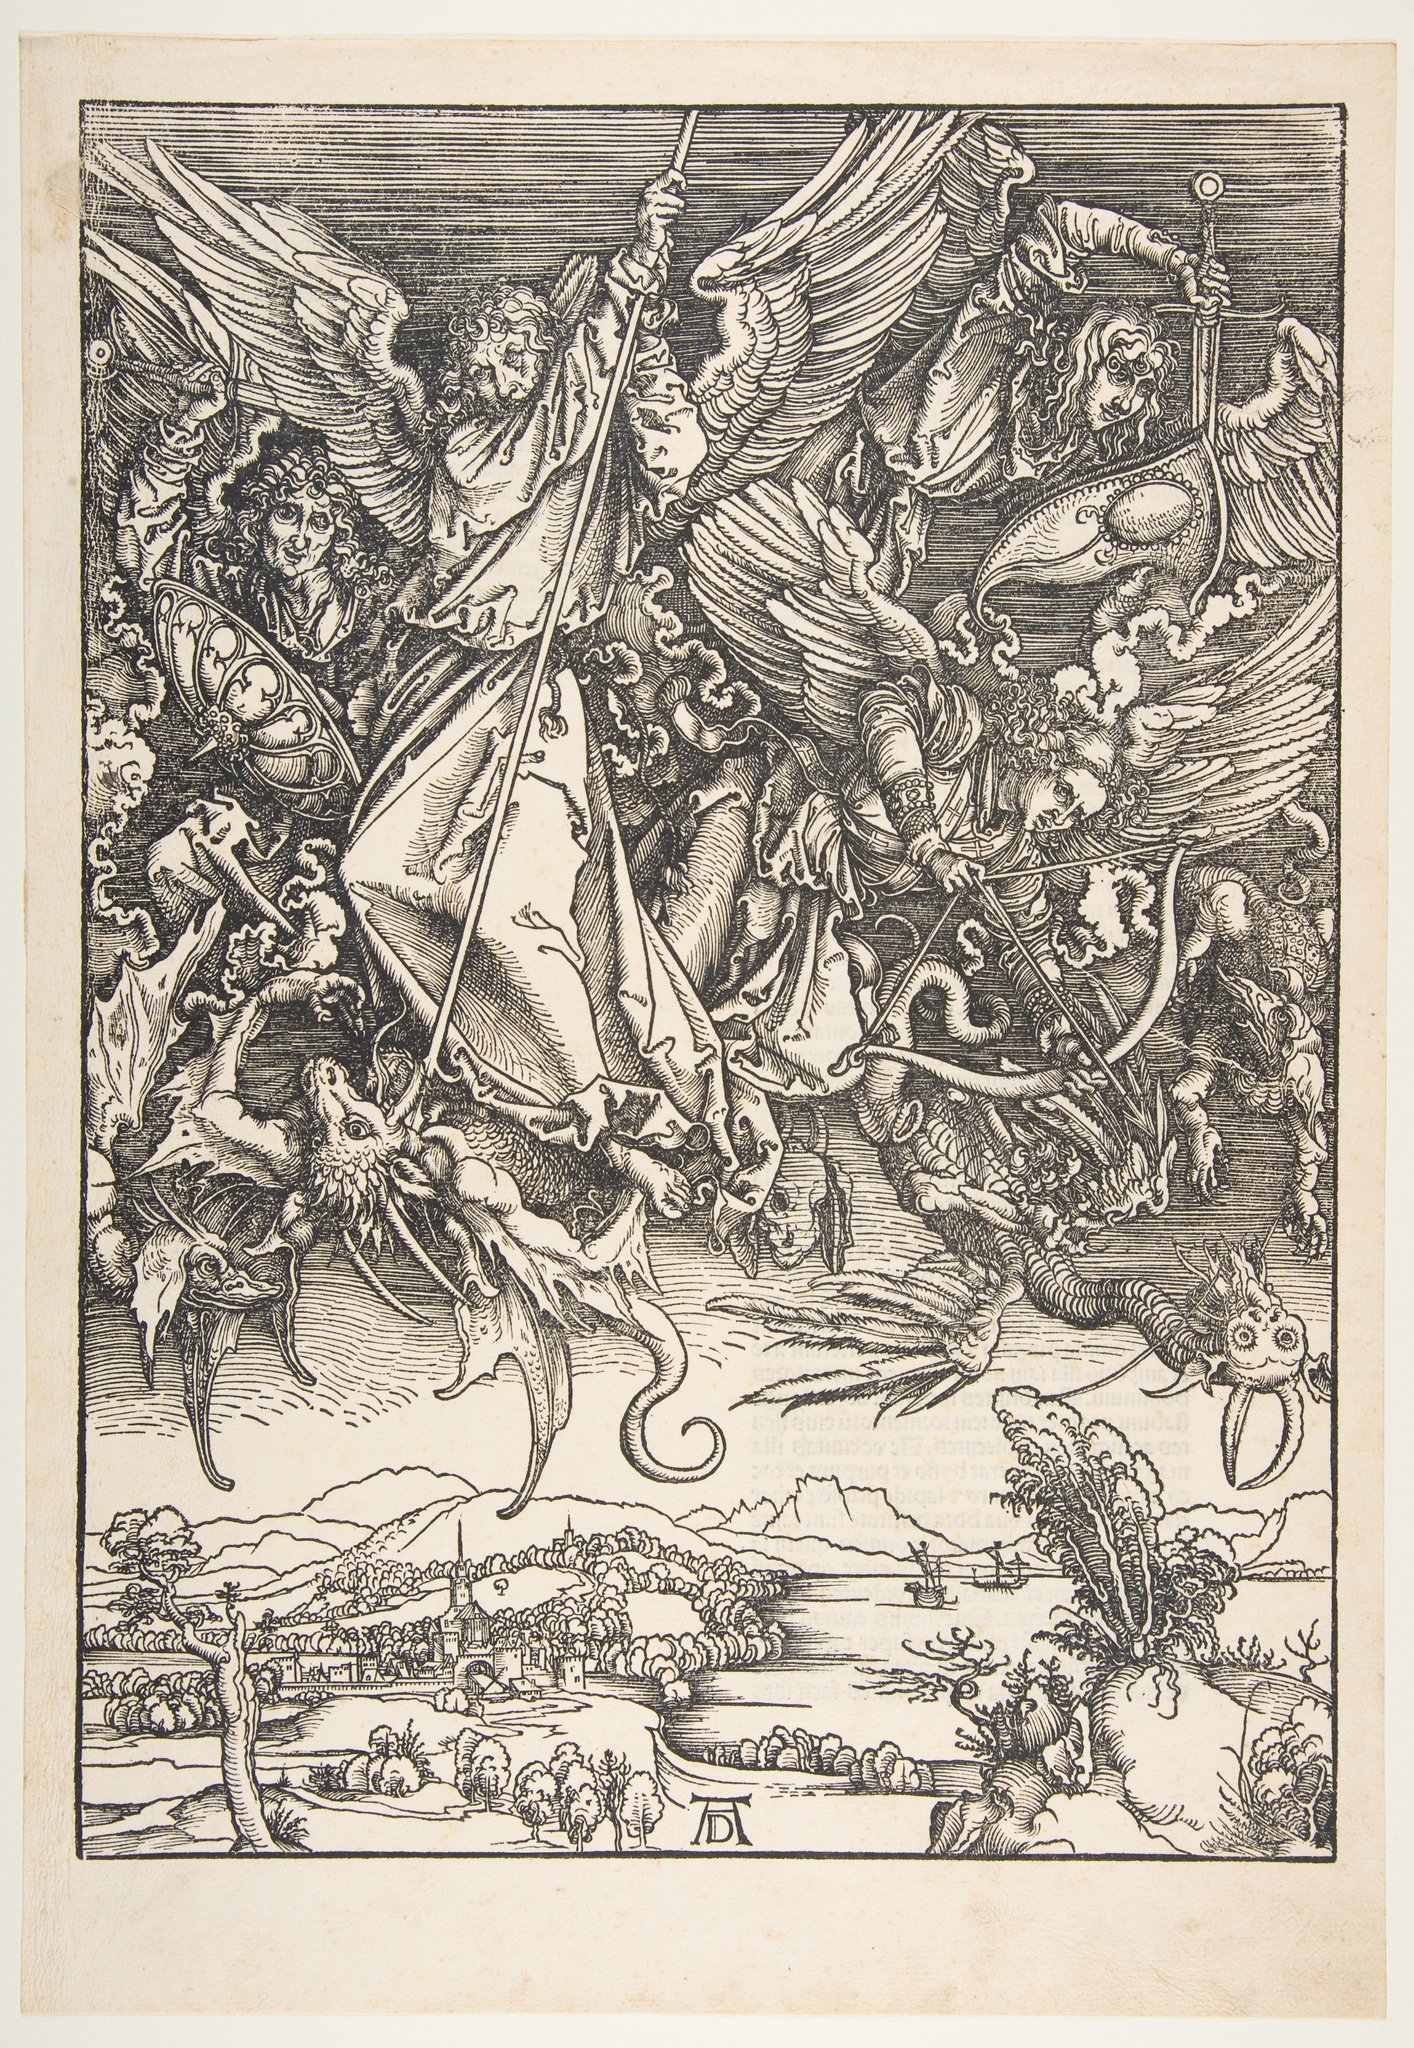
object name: print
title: Saint Michael Fighting the Dragon, from "The Apocalypse"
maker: albrecht dürer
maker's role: artist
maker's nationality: german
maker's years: 1471-1528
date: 1511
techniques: woodcut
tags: weapons,dragons,saint michael,apocalypse